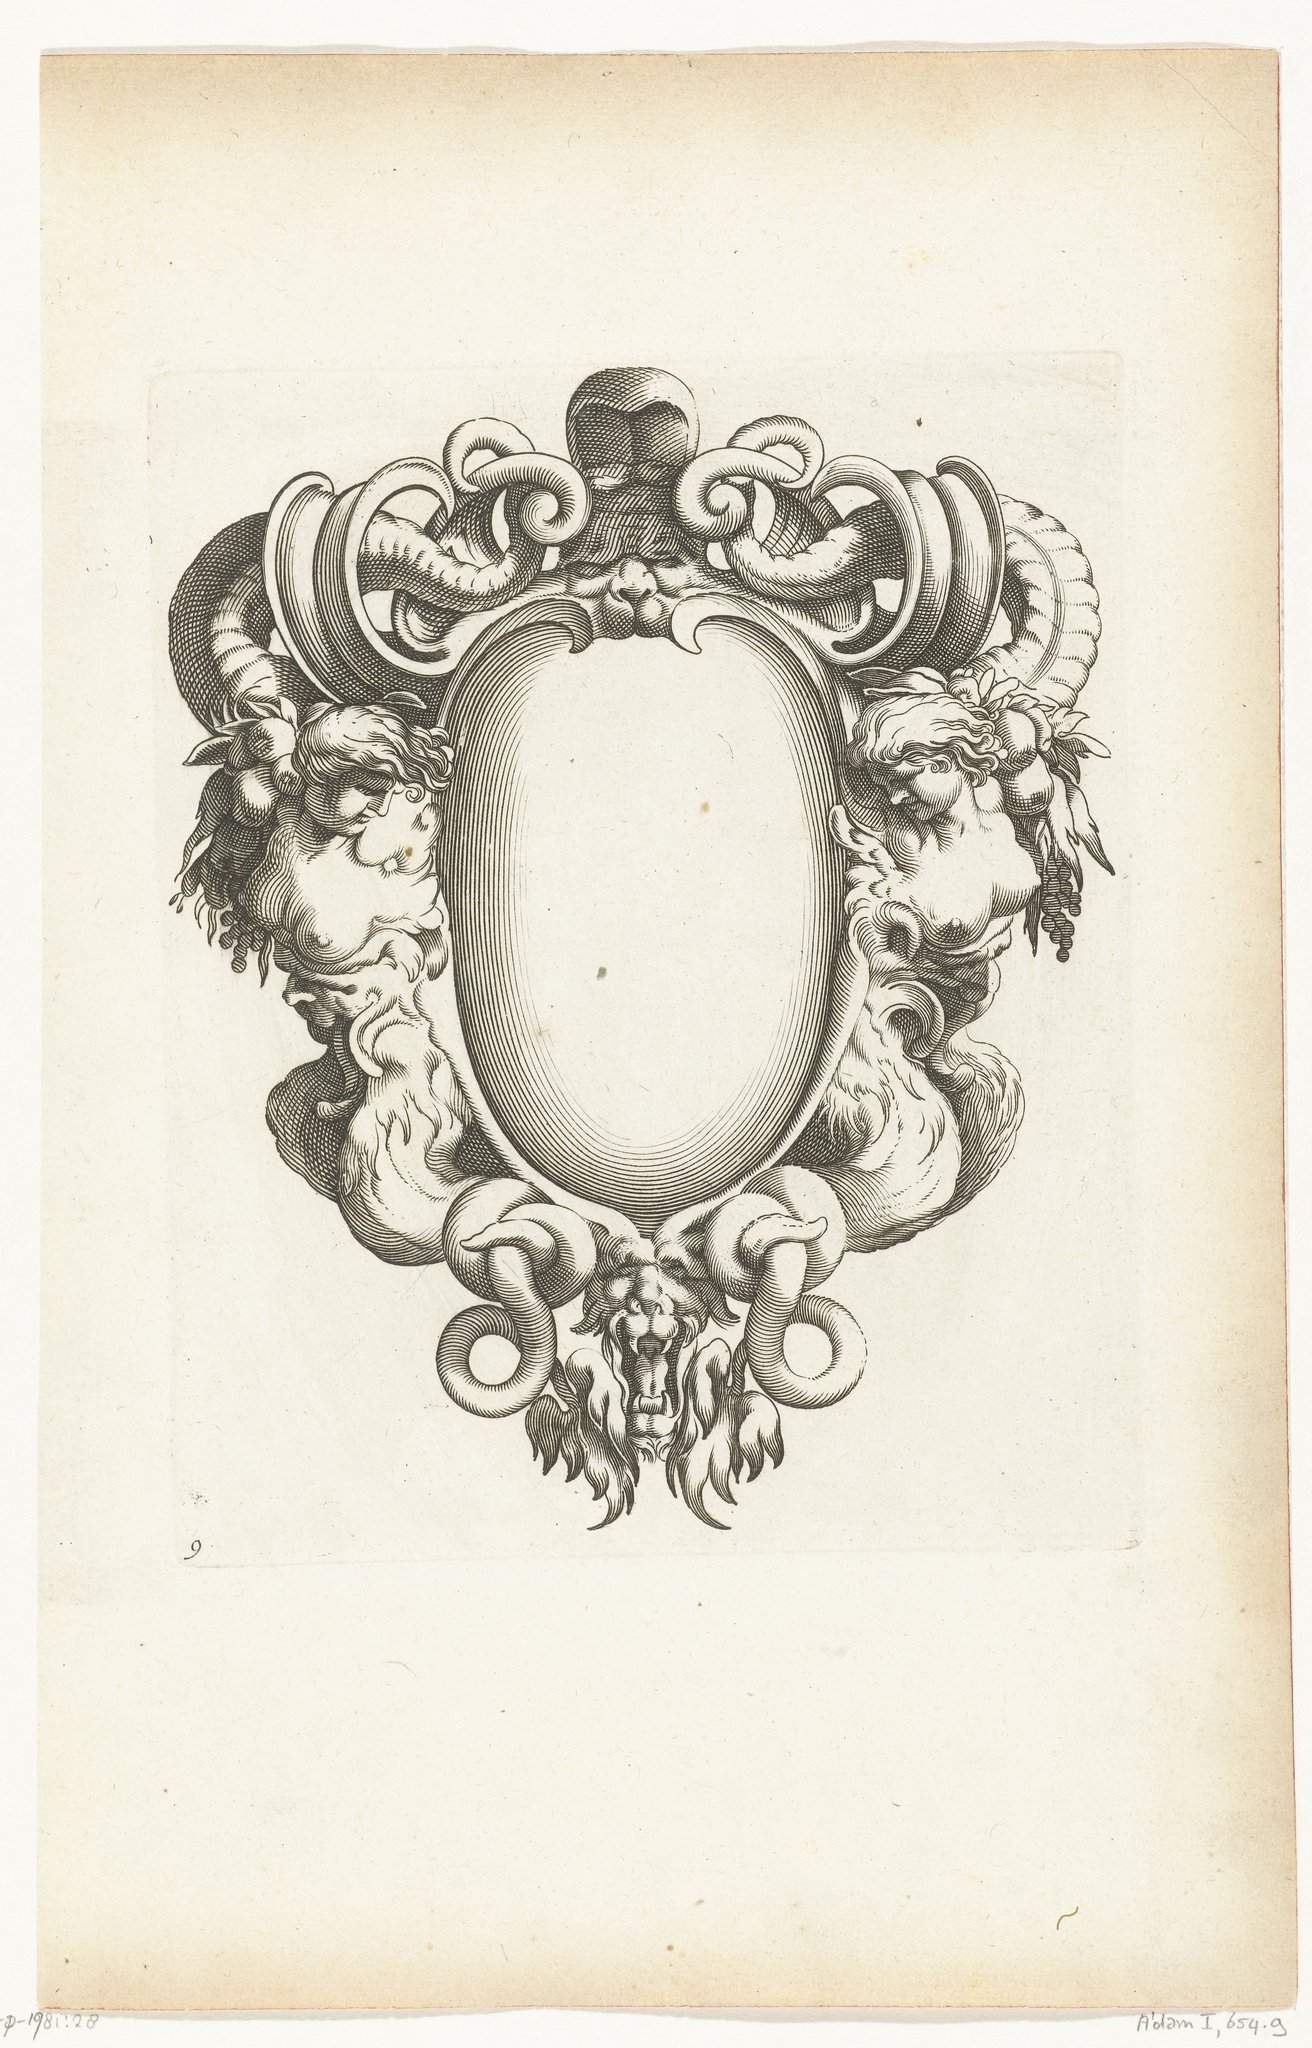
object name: print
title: Cartouches in omlijstingen van rolwerk met grotesken, guirlandes en mascarons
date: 1613-1657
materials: paper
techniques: engraving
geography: france